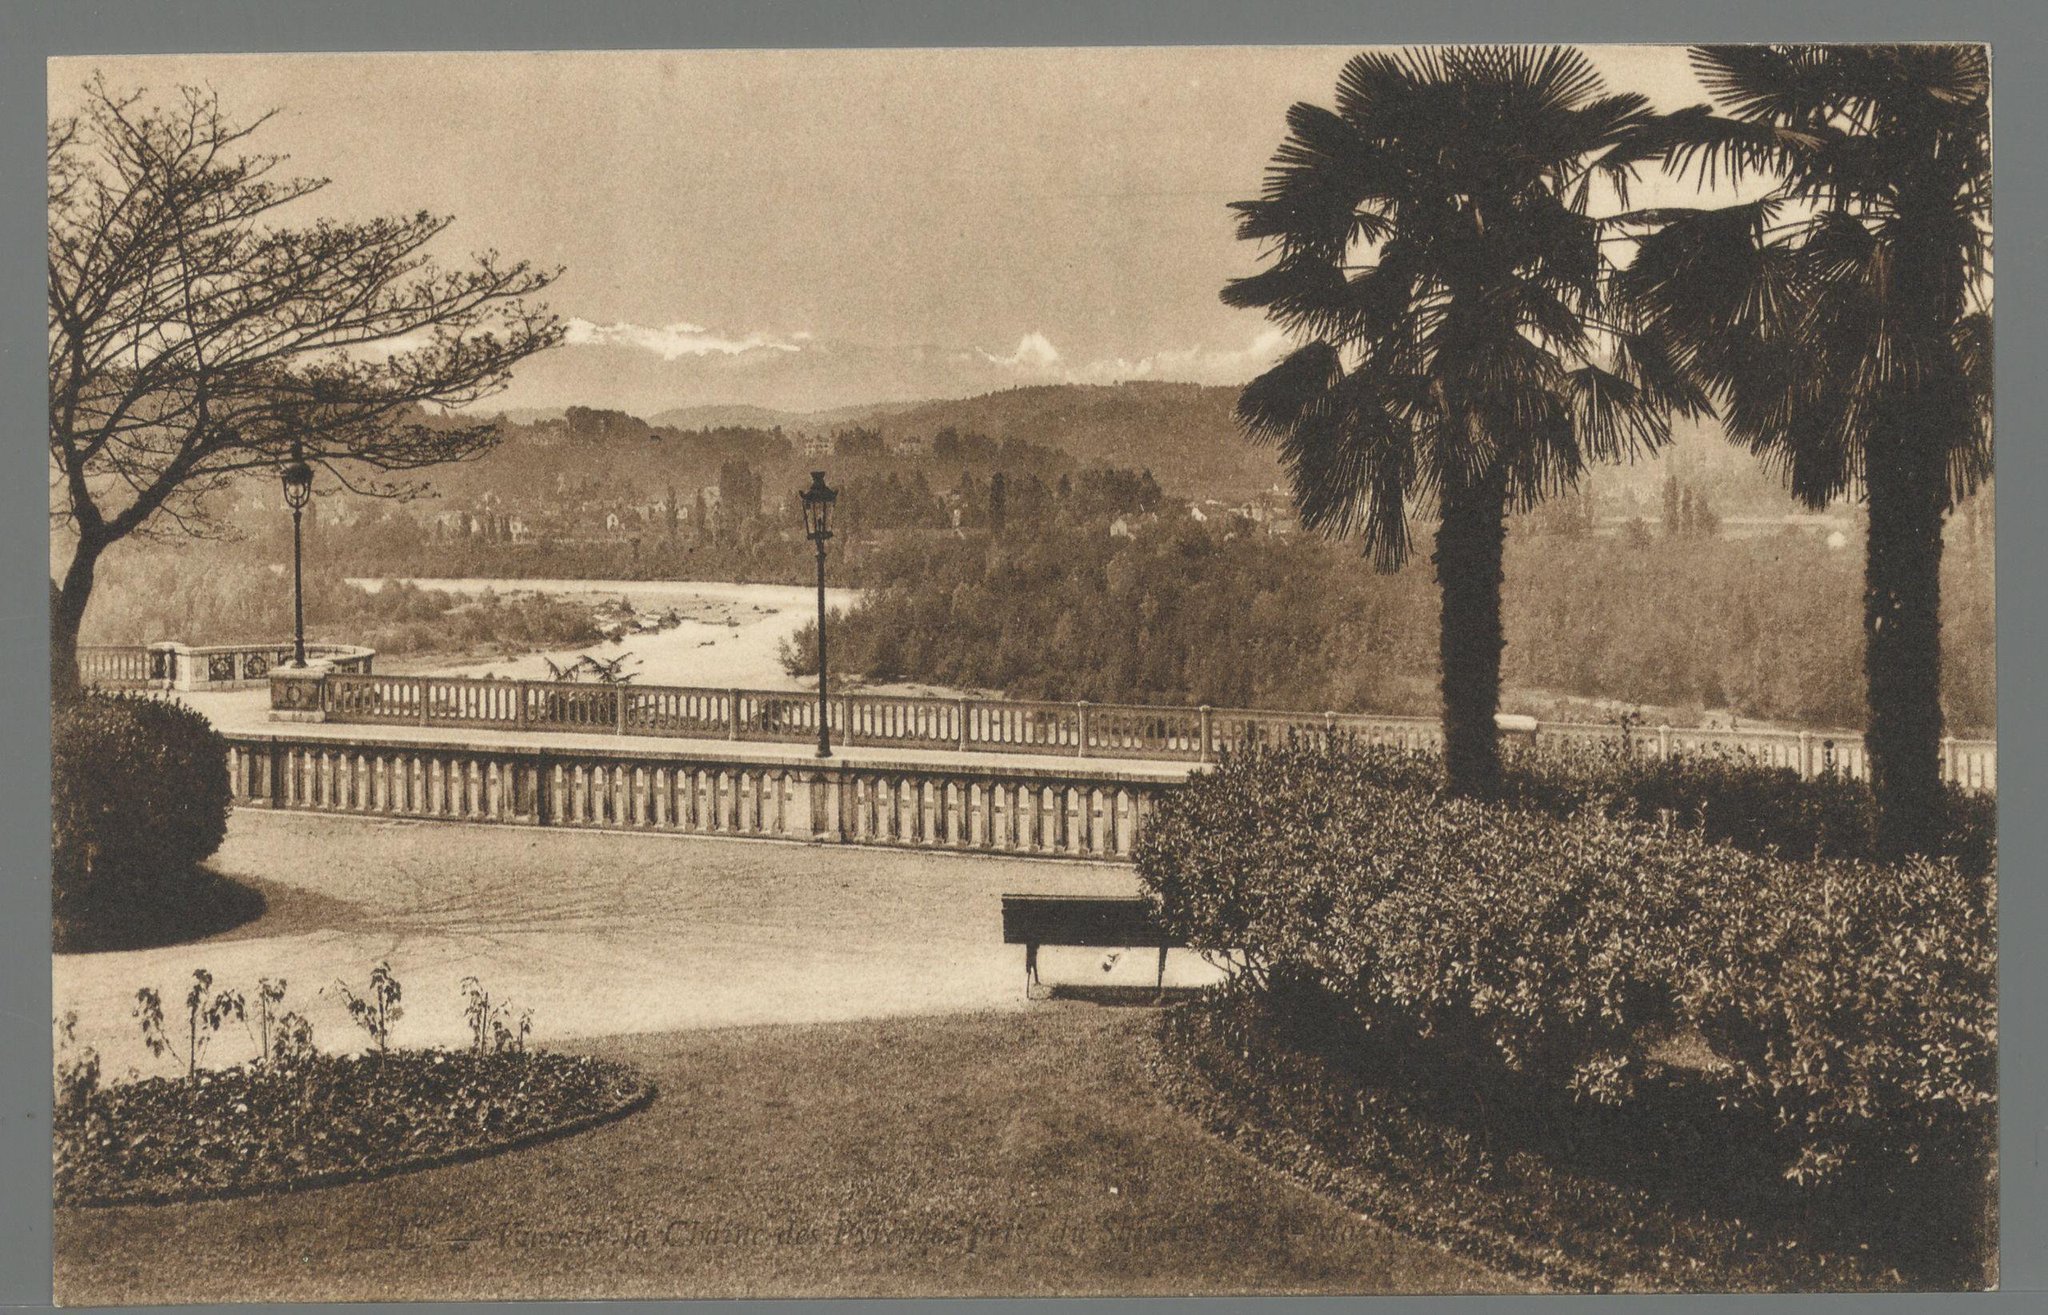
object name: ansichtkaart, prentbriefkaart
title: Poitiers. Eglise N.-D.-la-Grande. La vie mystique de la Vierge en l'Ancien et le Nouveau Testament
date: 1903-1922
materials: cardboard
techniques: photograph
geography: poitiers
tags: church (exterior), sculpture